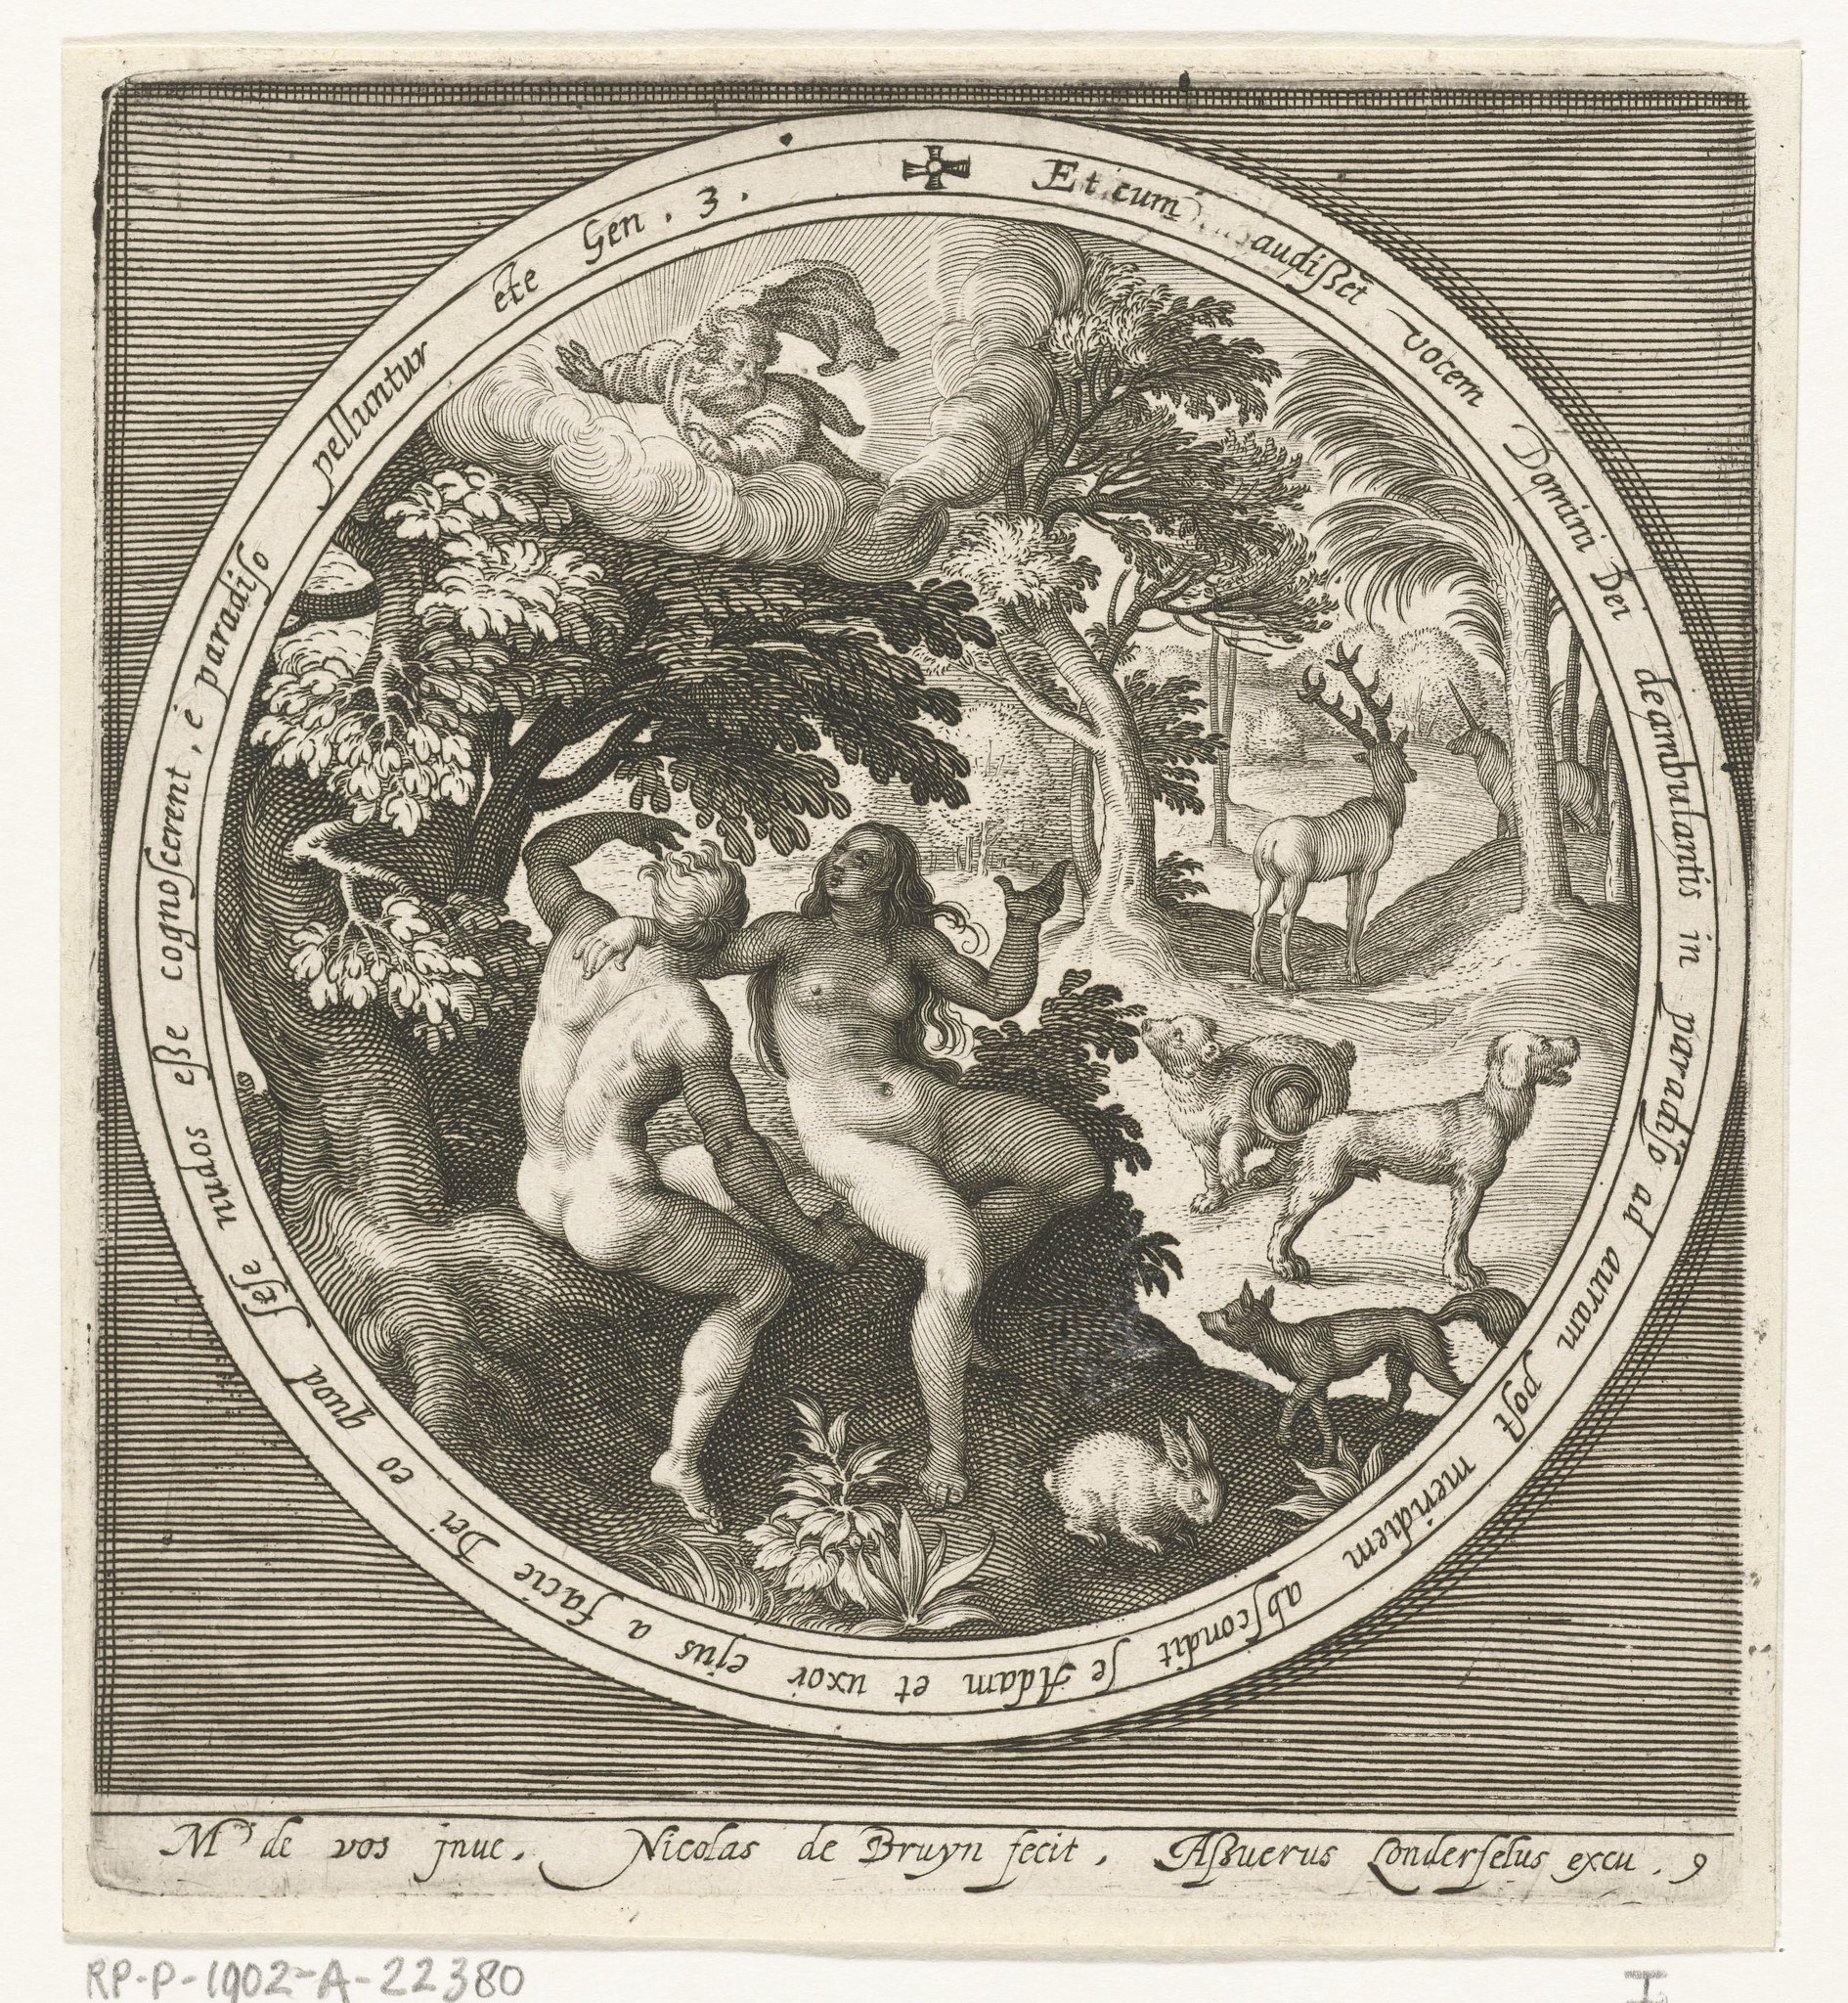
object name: print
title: Adam en Eva verbergen zich voor God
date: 1581-1656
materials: paper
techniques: engraving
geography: netherlands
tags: adam and eve discover their nakedness; they cover themselves with their hands or with leaves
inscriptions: collector's mark: Lugt 2228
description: Adam en Eva verbergen zich door schaamte over hun naaktheid voor God. In medaillon met als opschrift een bijbeltekst in Latijn uit Genesis 3, binnen rechthoekige omlijsting.